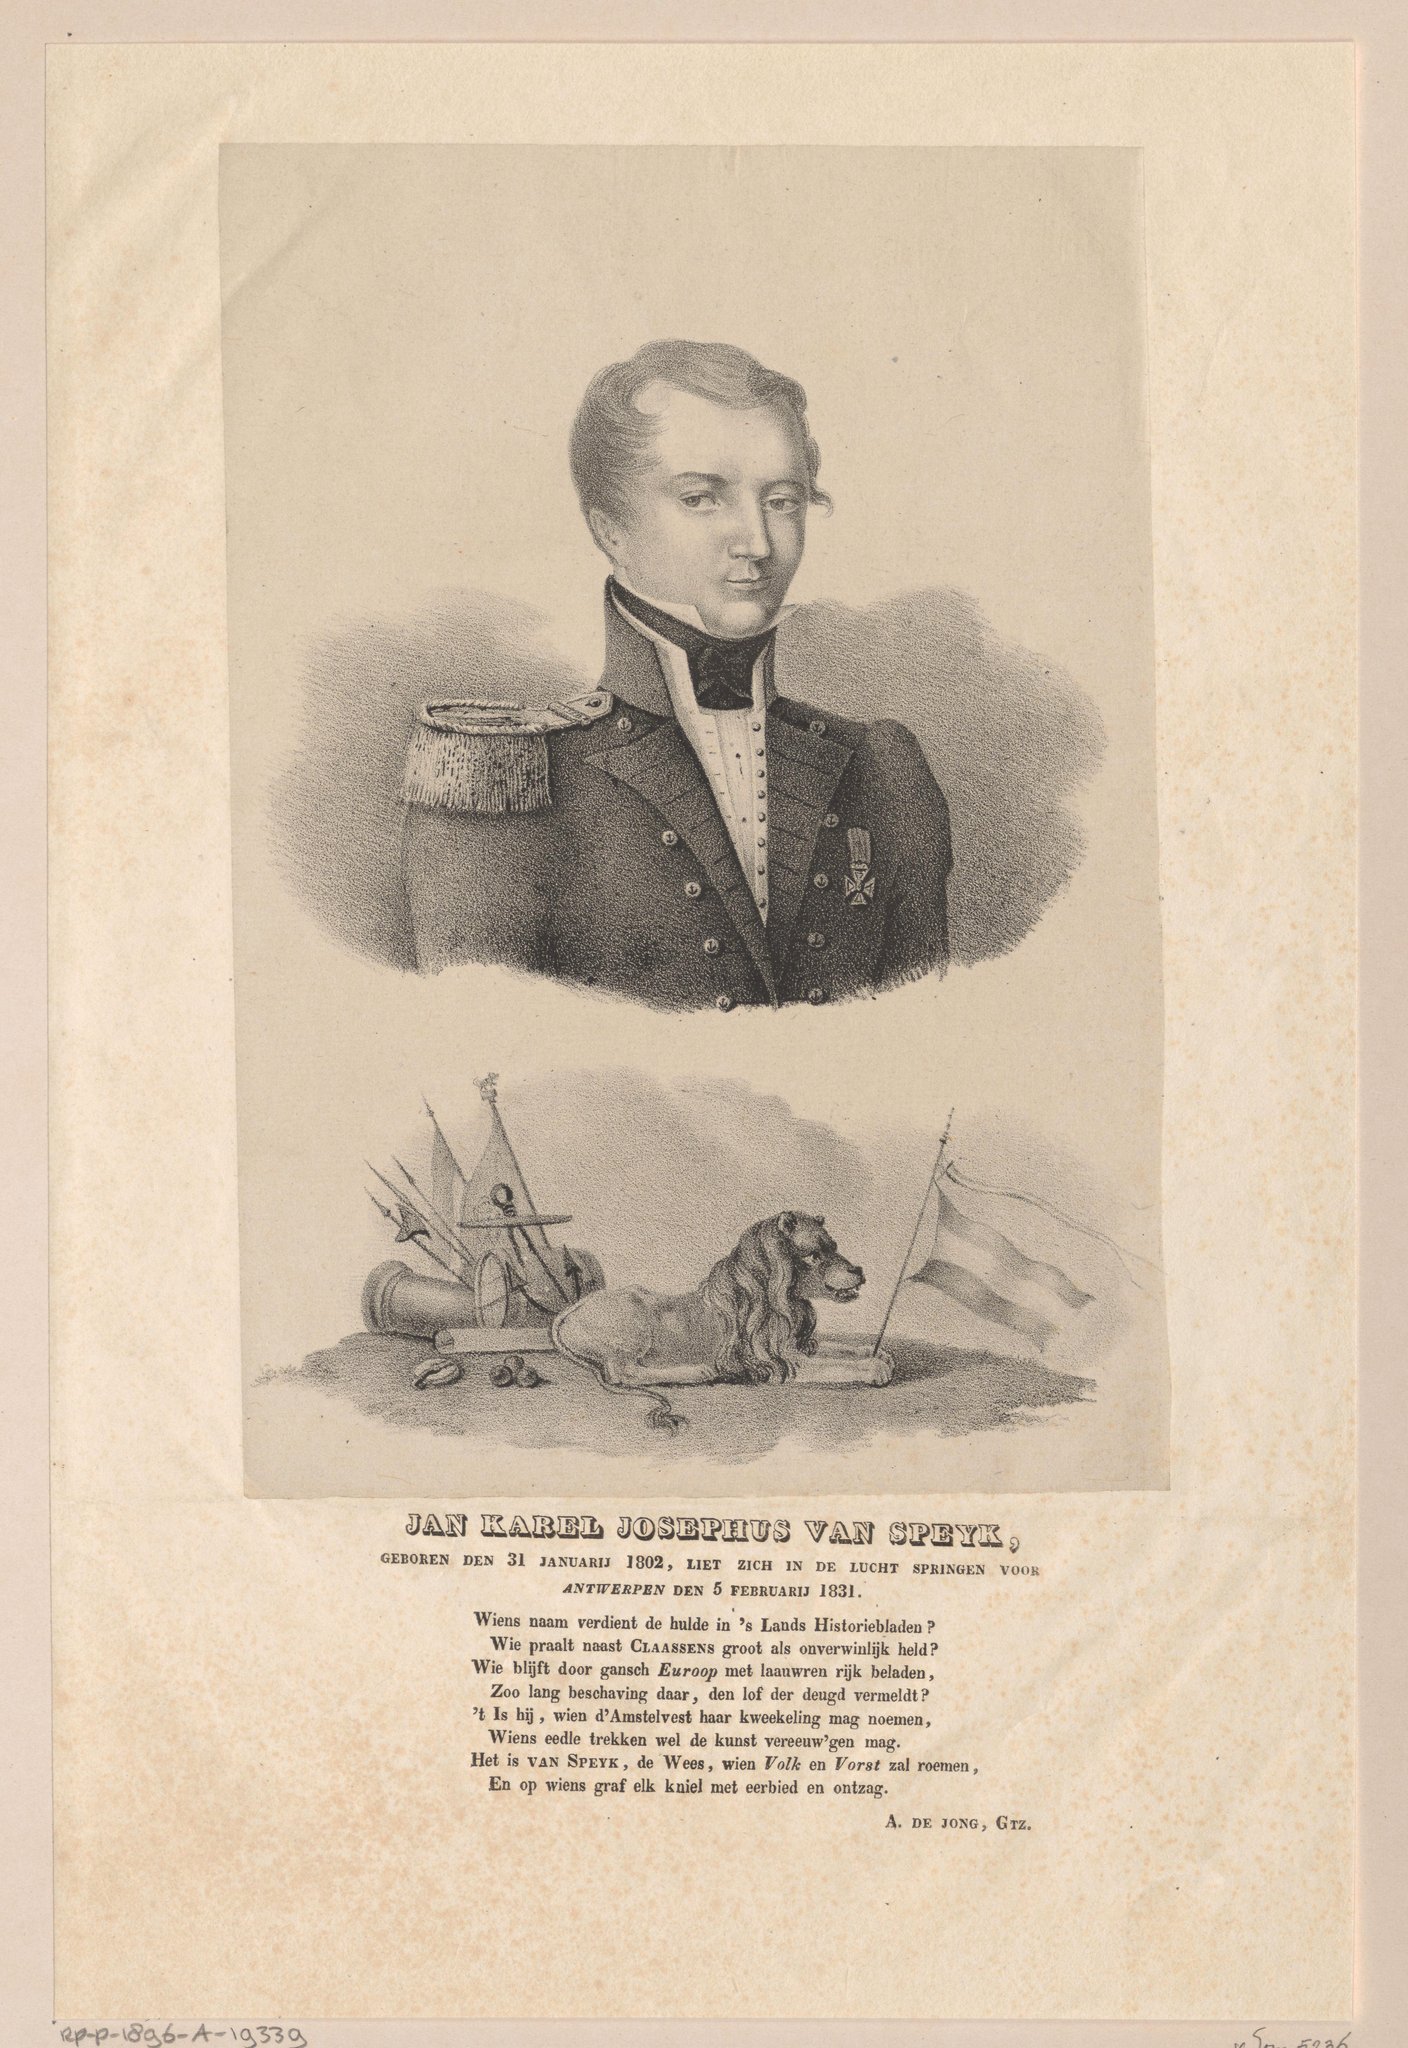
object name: print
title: Portret van Jan van Speyk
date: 1831-1899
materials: paper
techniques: letterpress printing, lithograph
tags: amsterdam, antwerp, jan van speyk, historical persons, commander-in-chief, admiral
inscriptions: collector's mark: Lugt 2228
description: Met tienregelig onderschrift in het Nederlands.